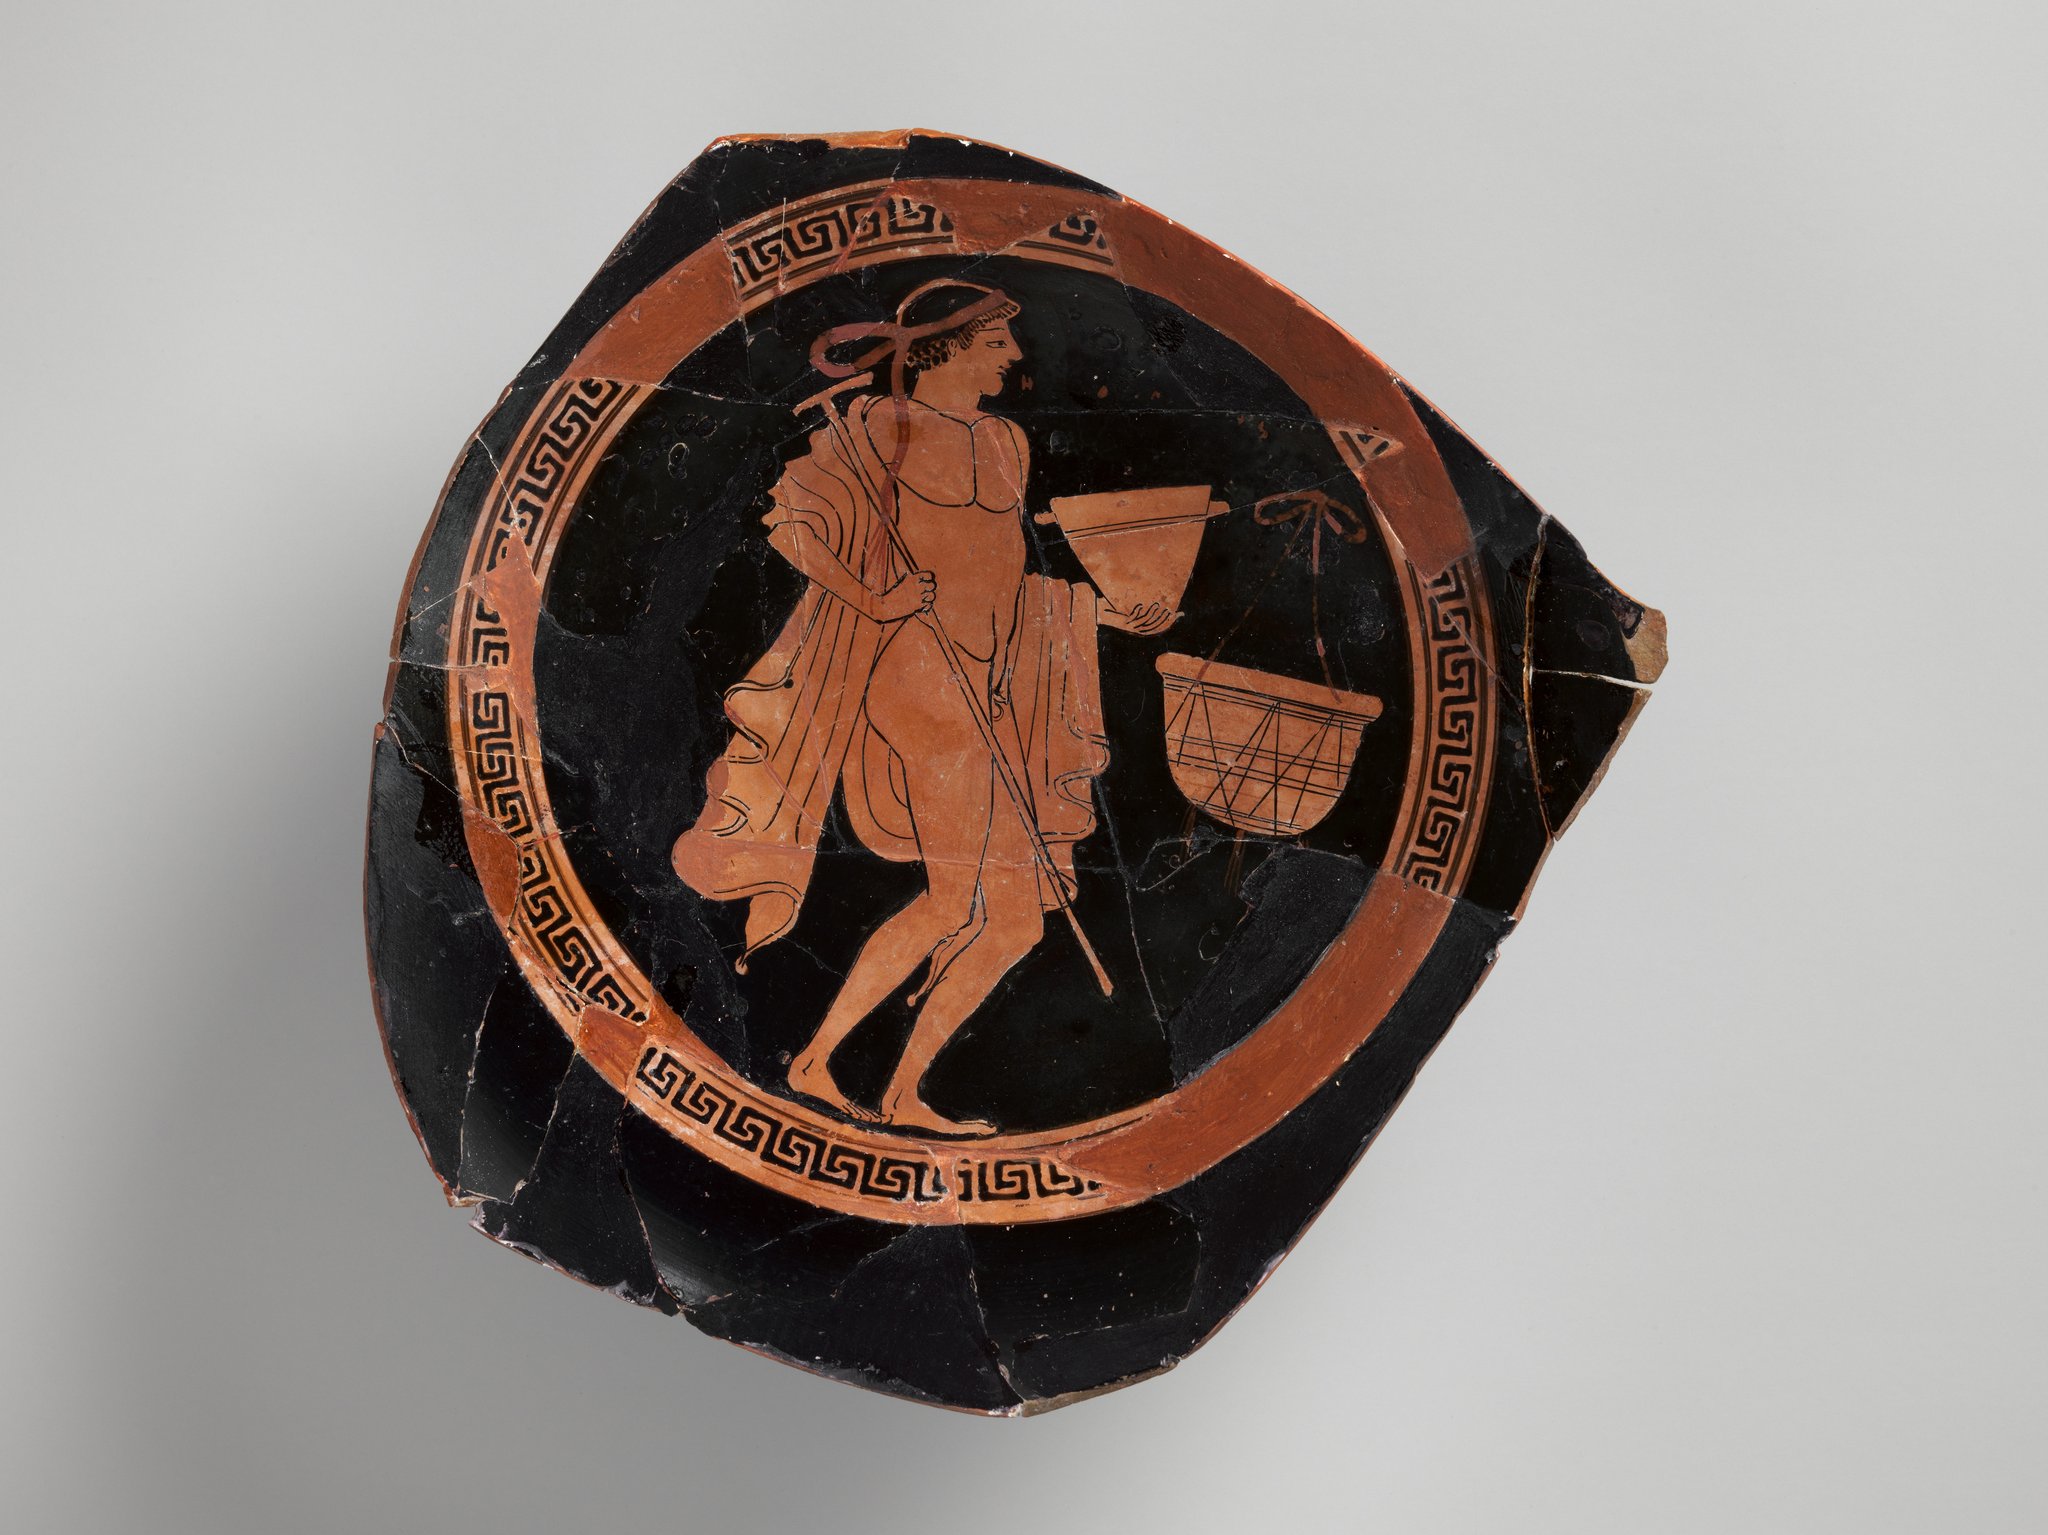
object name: kylix fragment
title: Kylix fragments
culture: greek, attic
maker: antiphon painter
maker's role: artist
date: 450 BCE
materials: terracotta